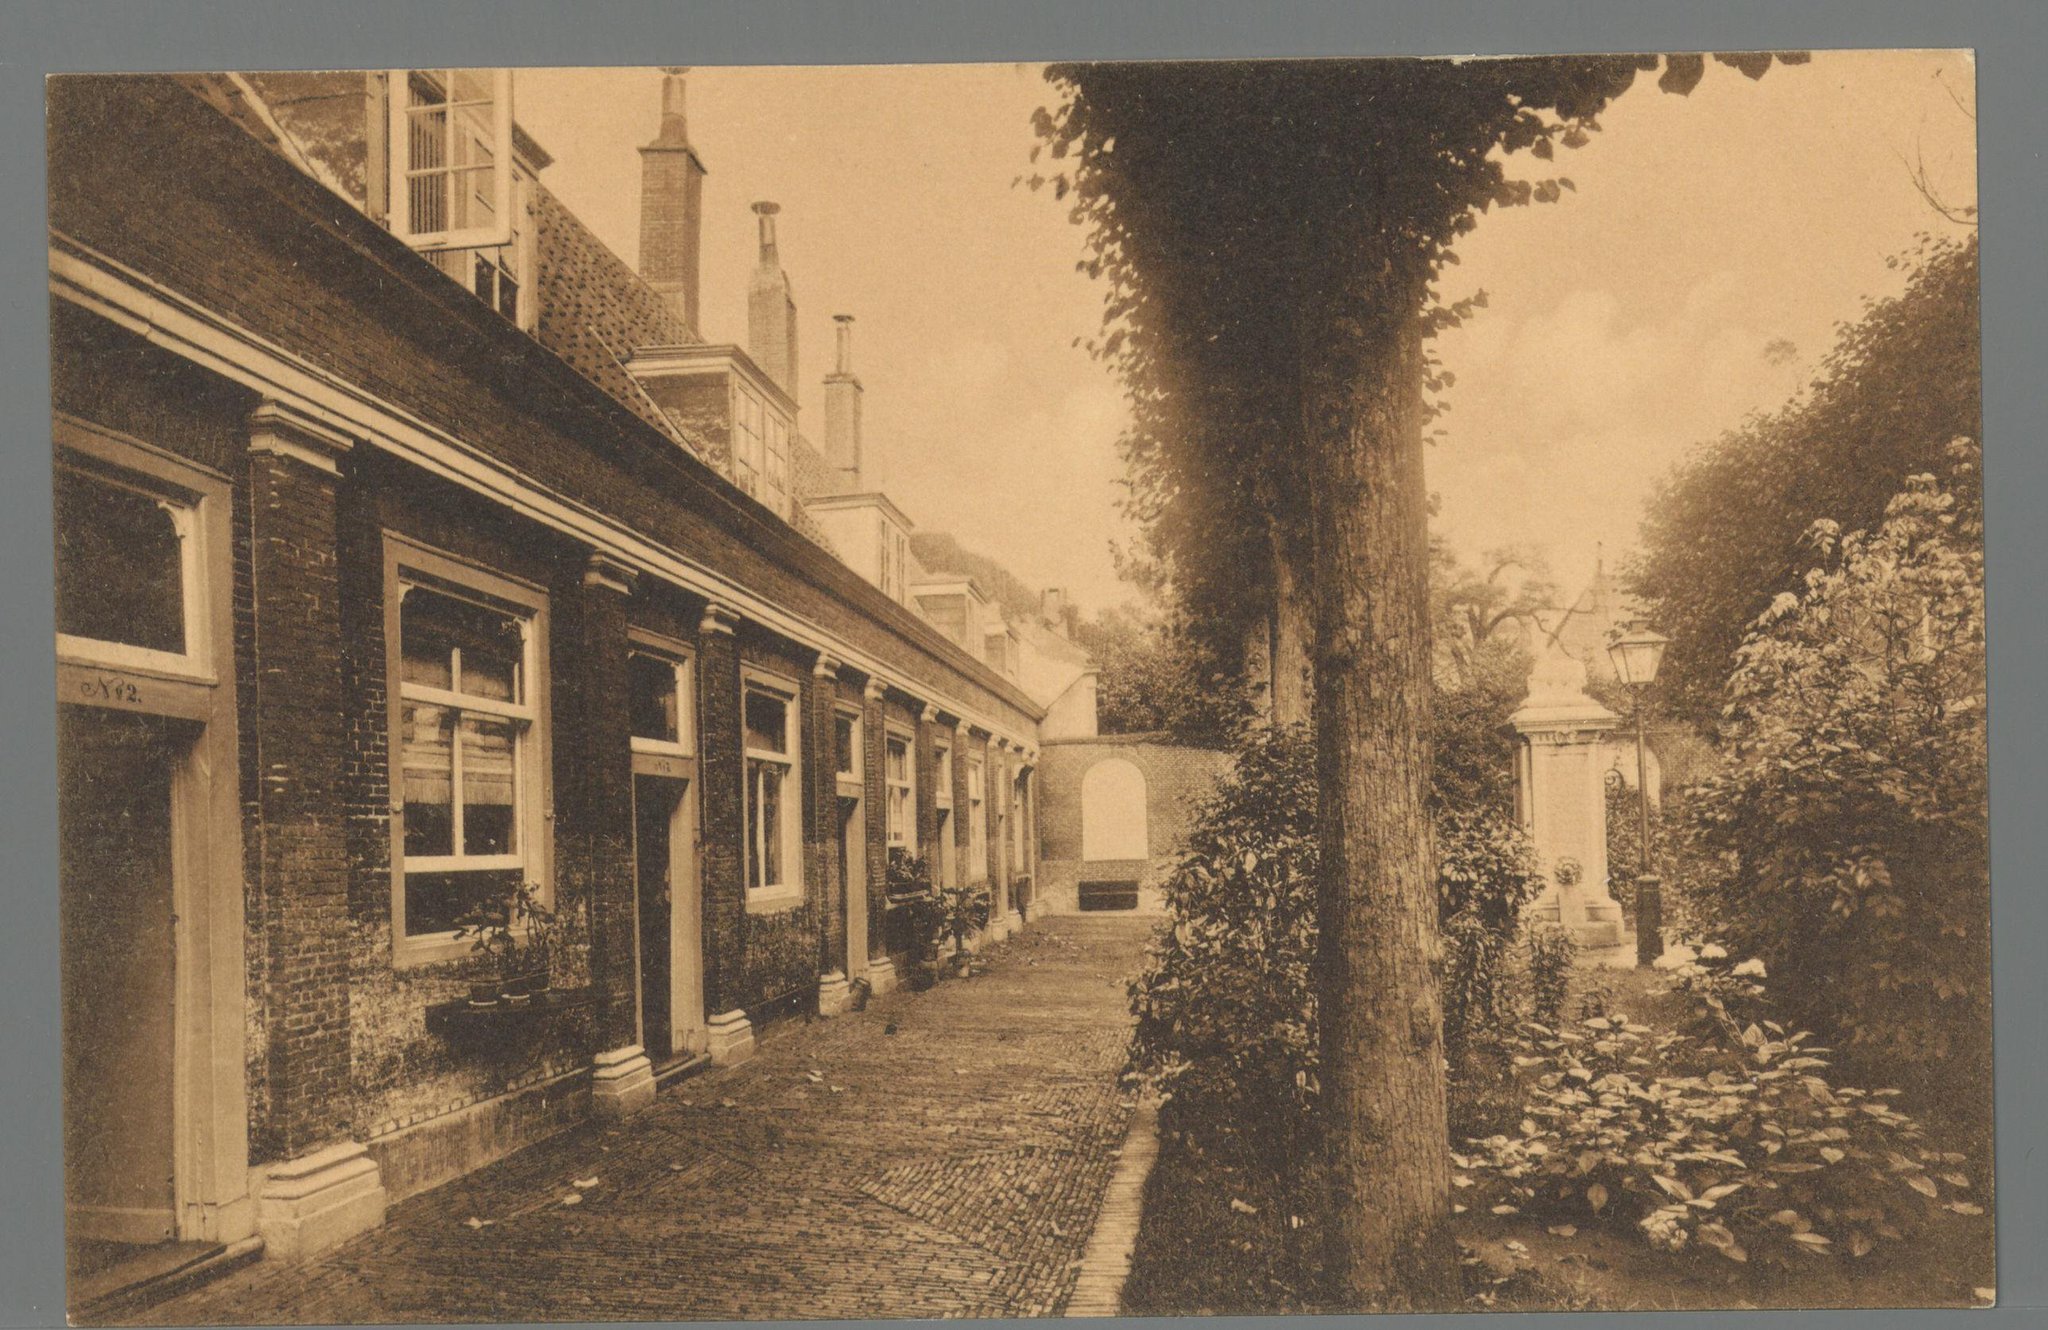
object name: ansichtkaart, prentbriefkaart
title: Leiden. Hofje van Eva v. Hoogeveen - Doelensteeg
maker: Anonymous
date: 1910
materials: cardboard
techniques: photograph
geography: leipzig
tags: alms-house (dutch: 'hofje')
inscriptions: date